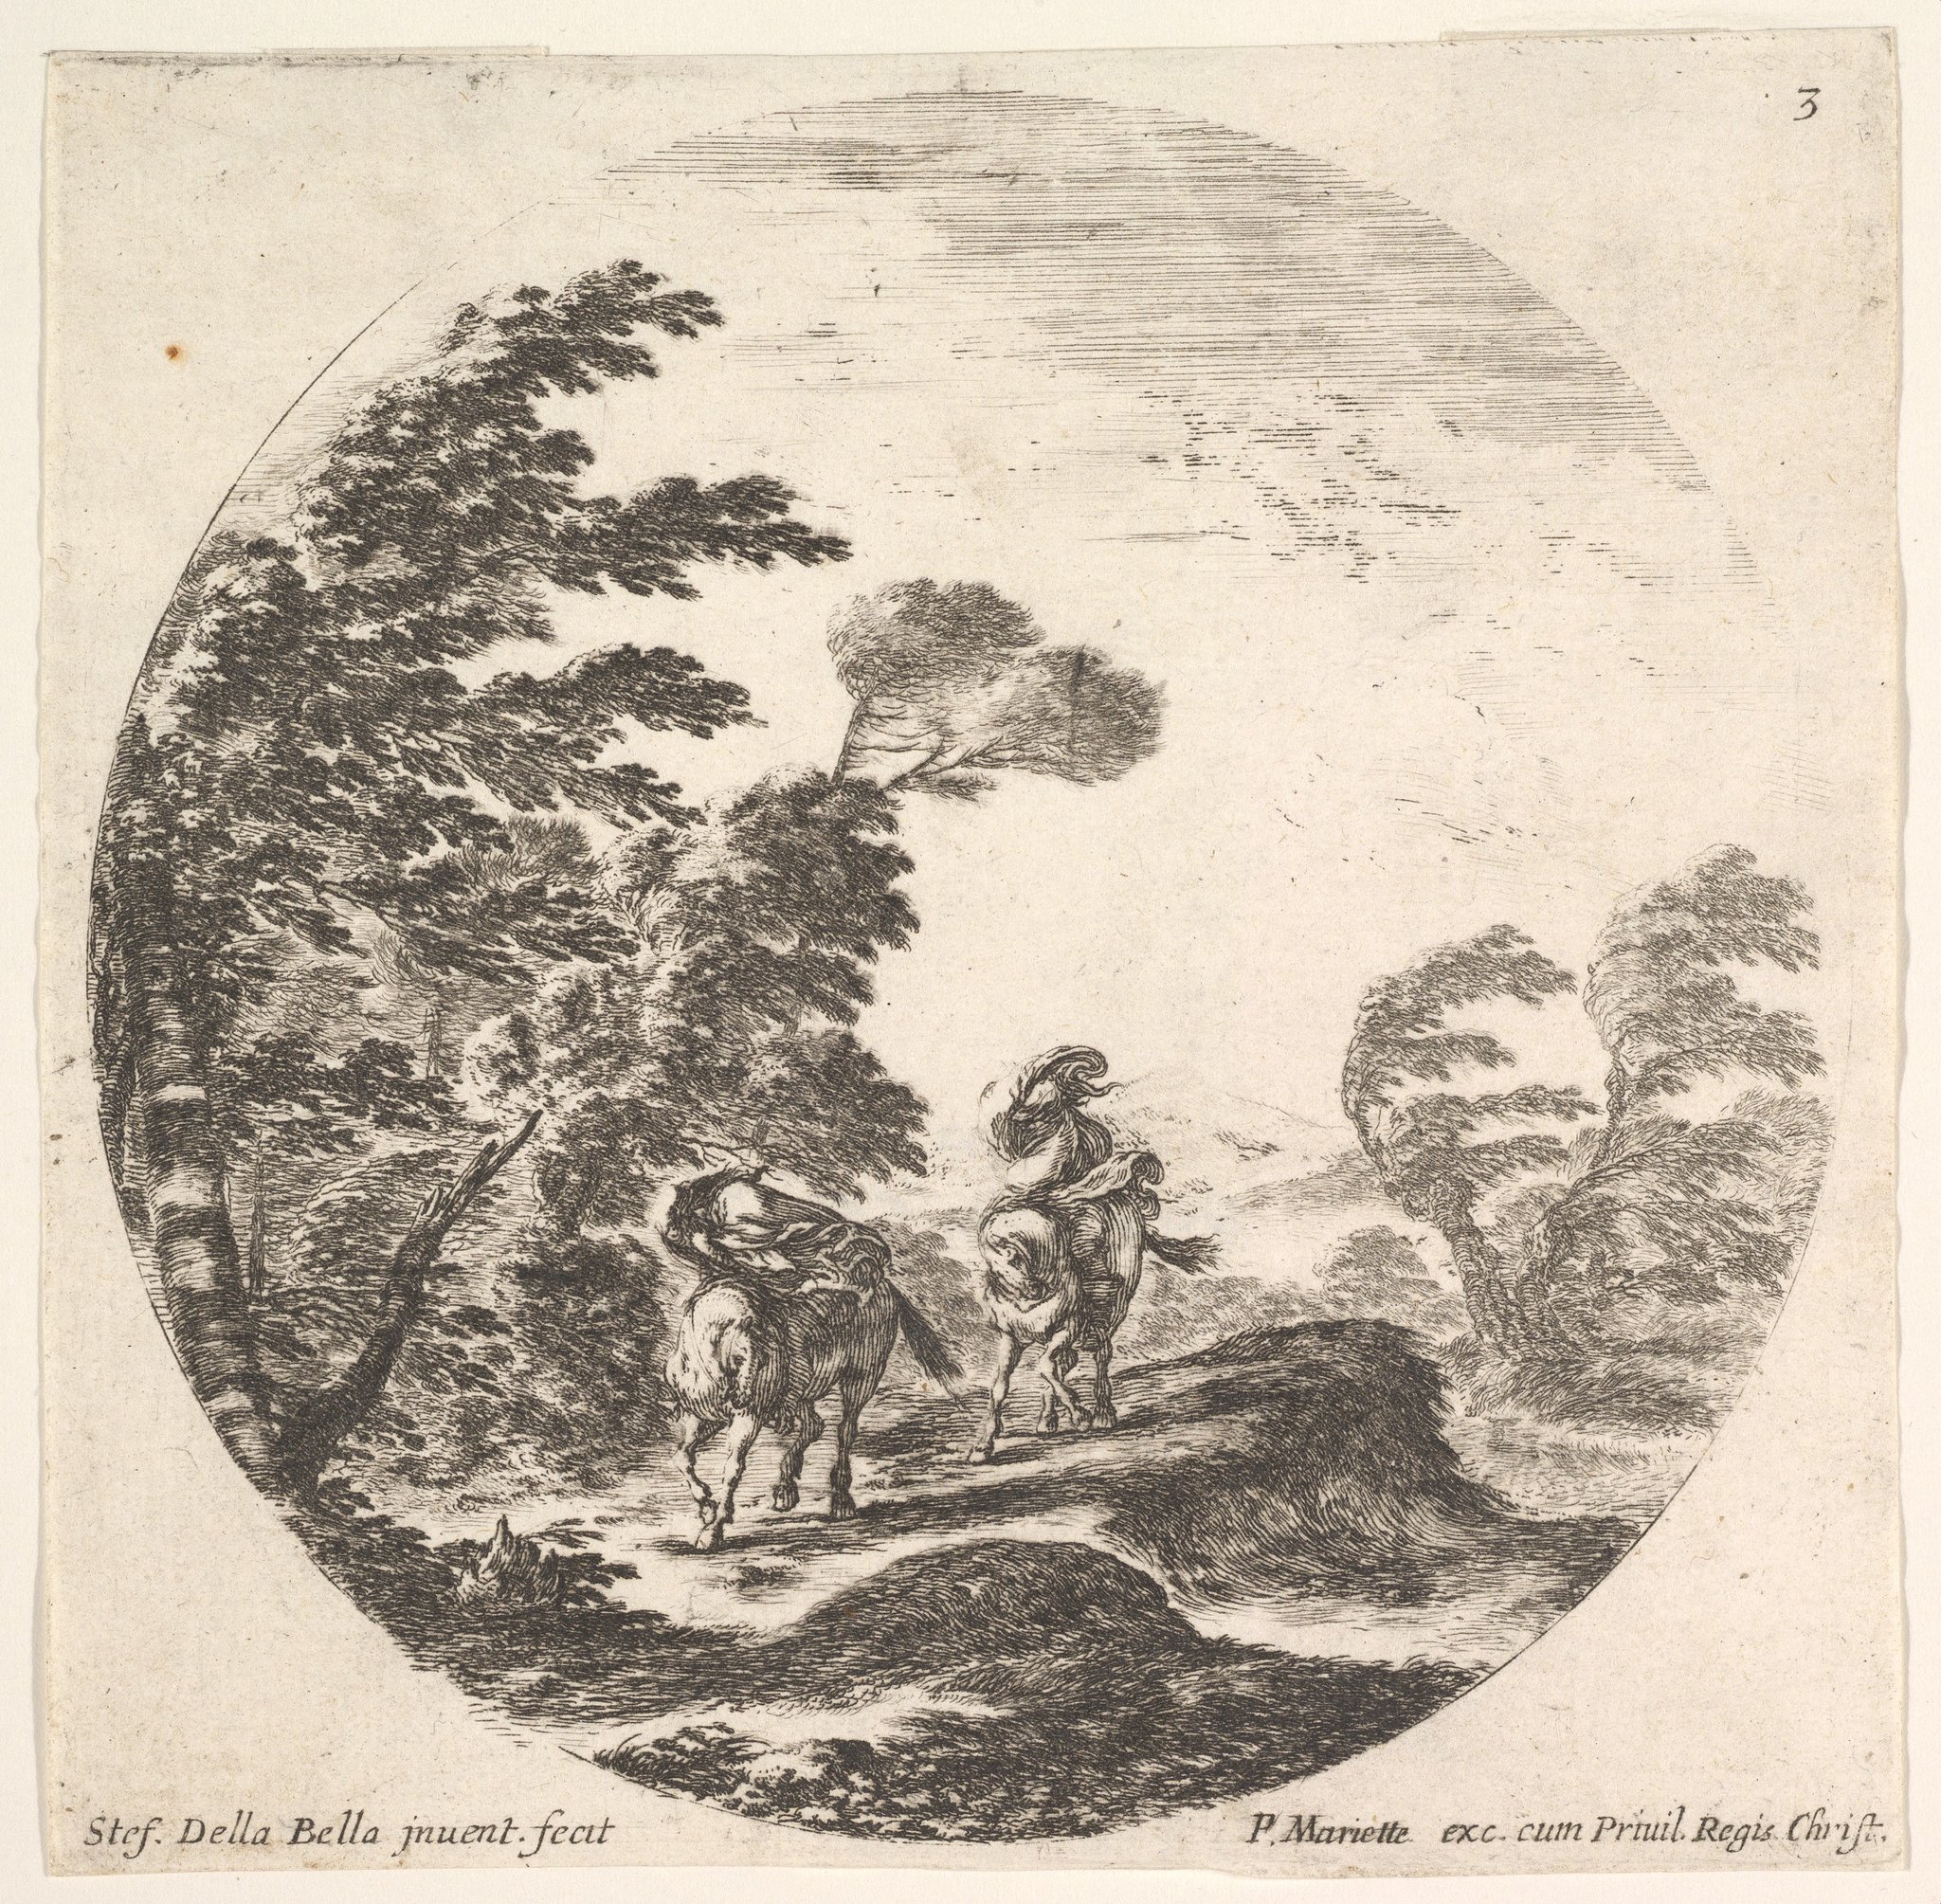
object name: print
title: Plate 3: a gale in the forest, two horsemen wrapped in their cloaks, the wind blowing, from "Roman landscapes and ruins" (Paysages et ruines de Rome)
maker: stefano della bella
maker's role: artist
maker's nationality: italian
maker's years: 1610-1664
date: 1643-1648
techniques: etching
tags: men,horses,landscapes,trees